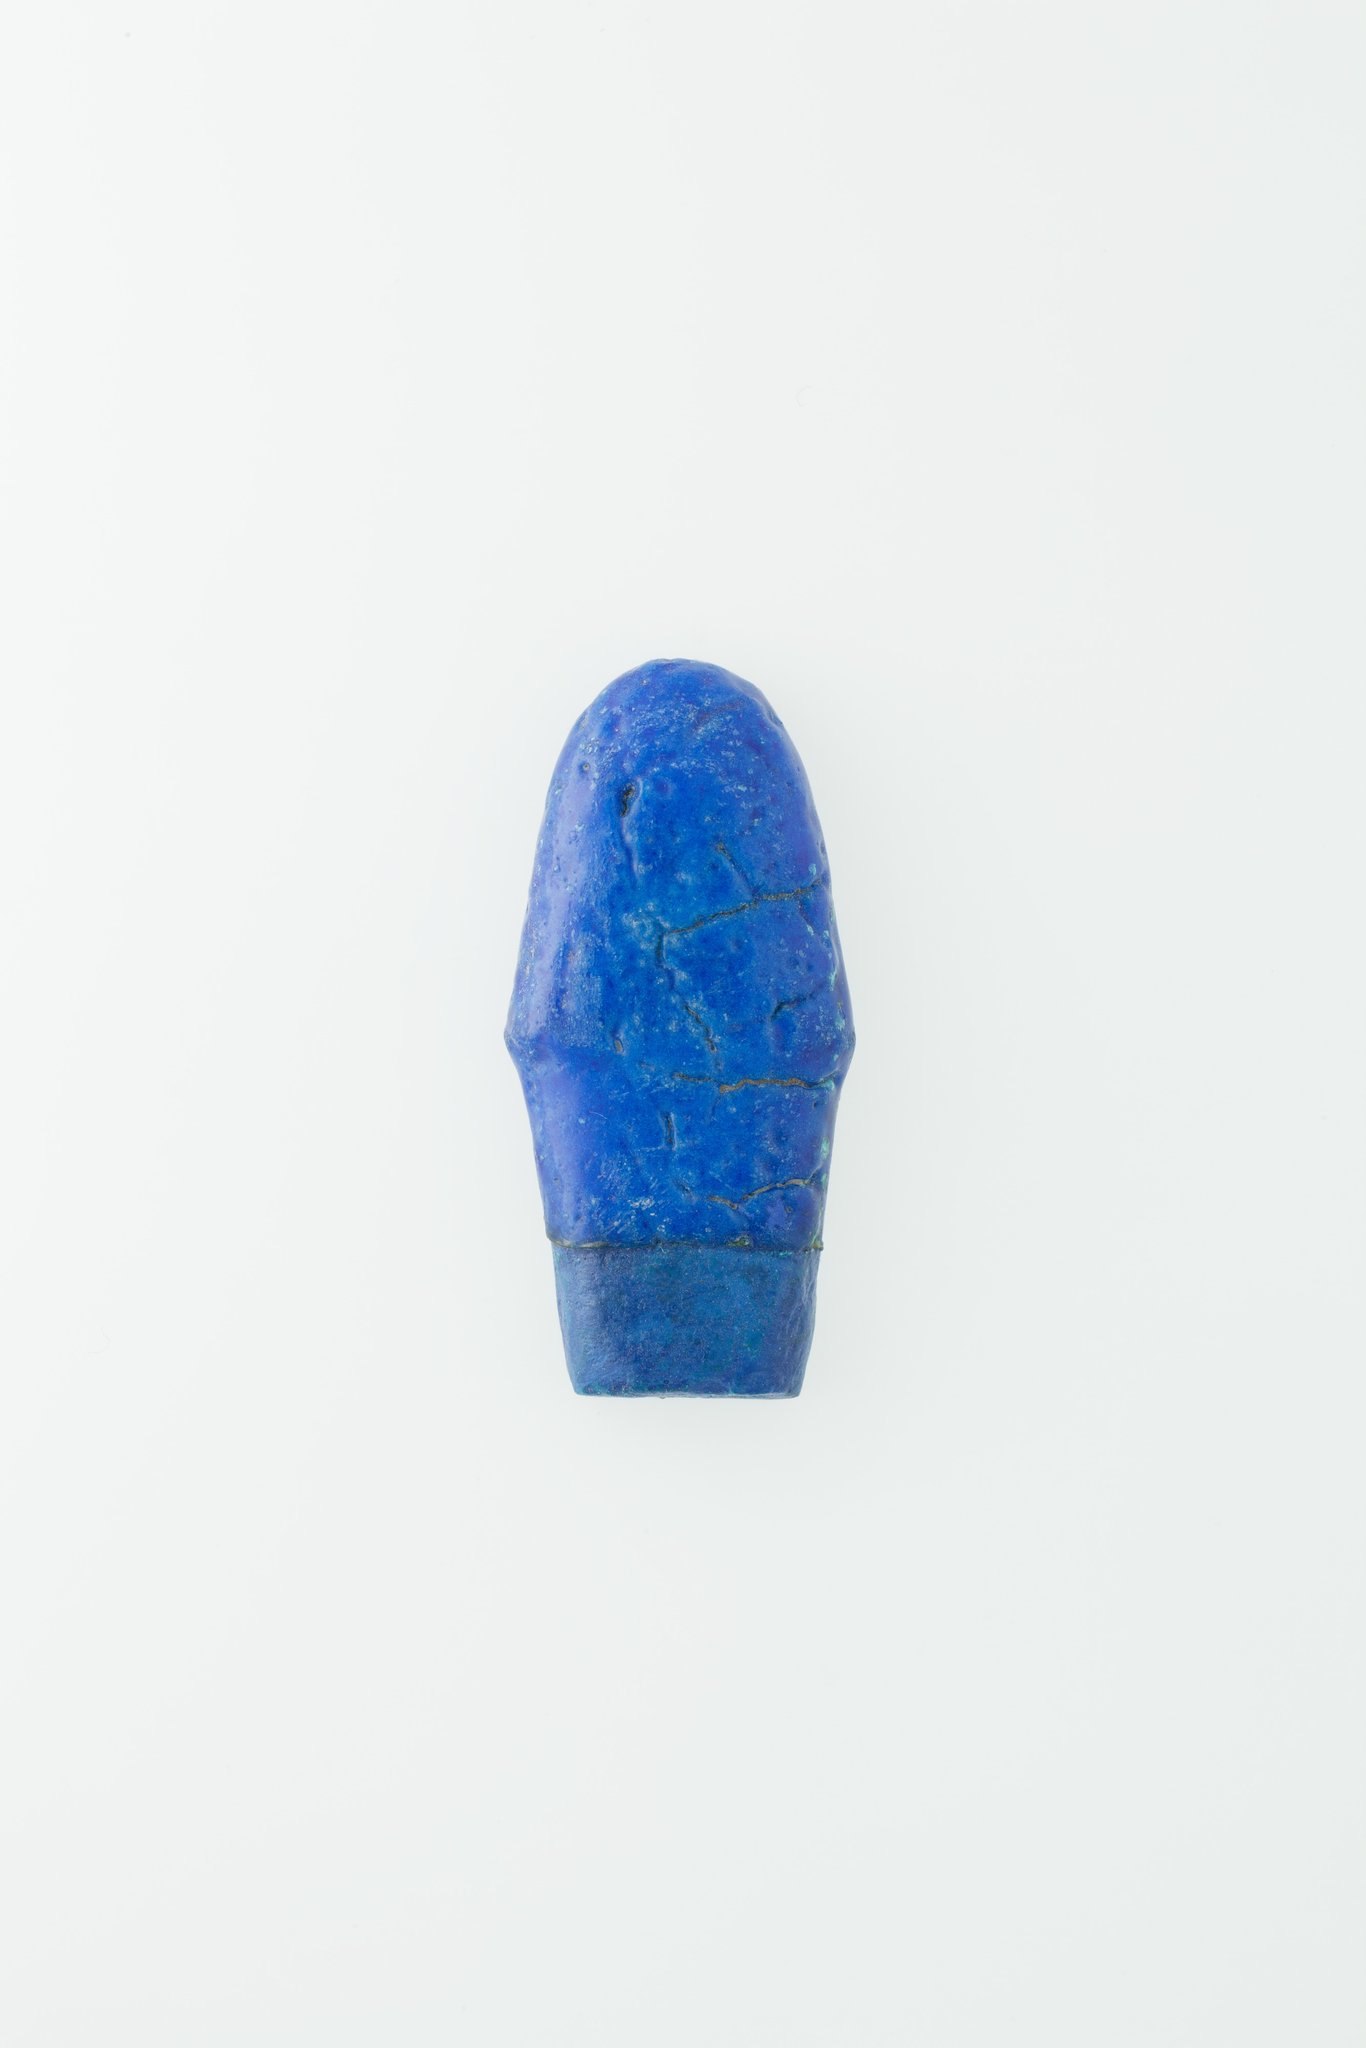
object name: inlay, hieroglyph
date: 664-610 BCE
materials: faience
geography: egypt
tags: hieroglyphs